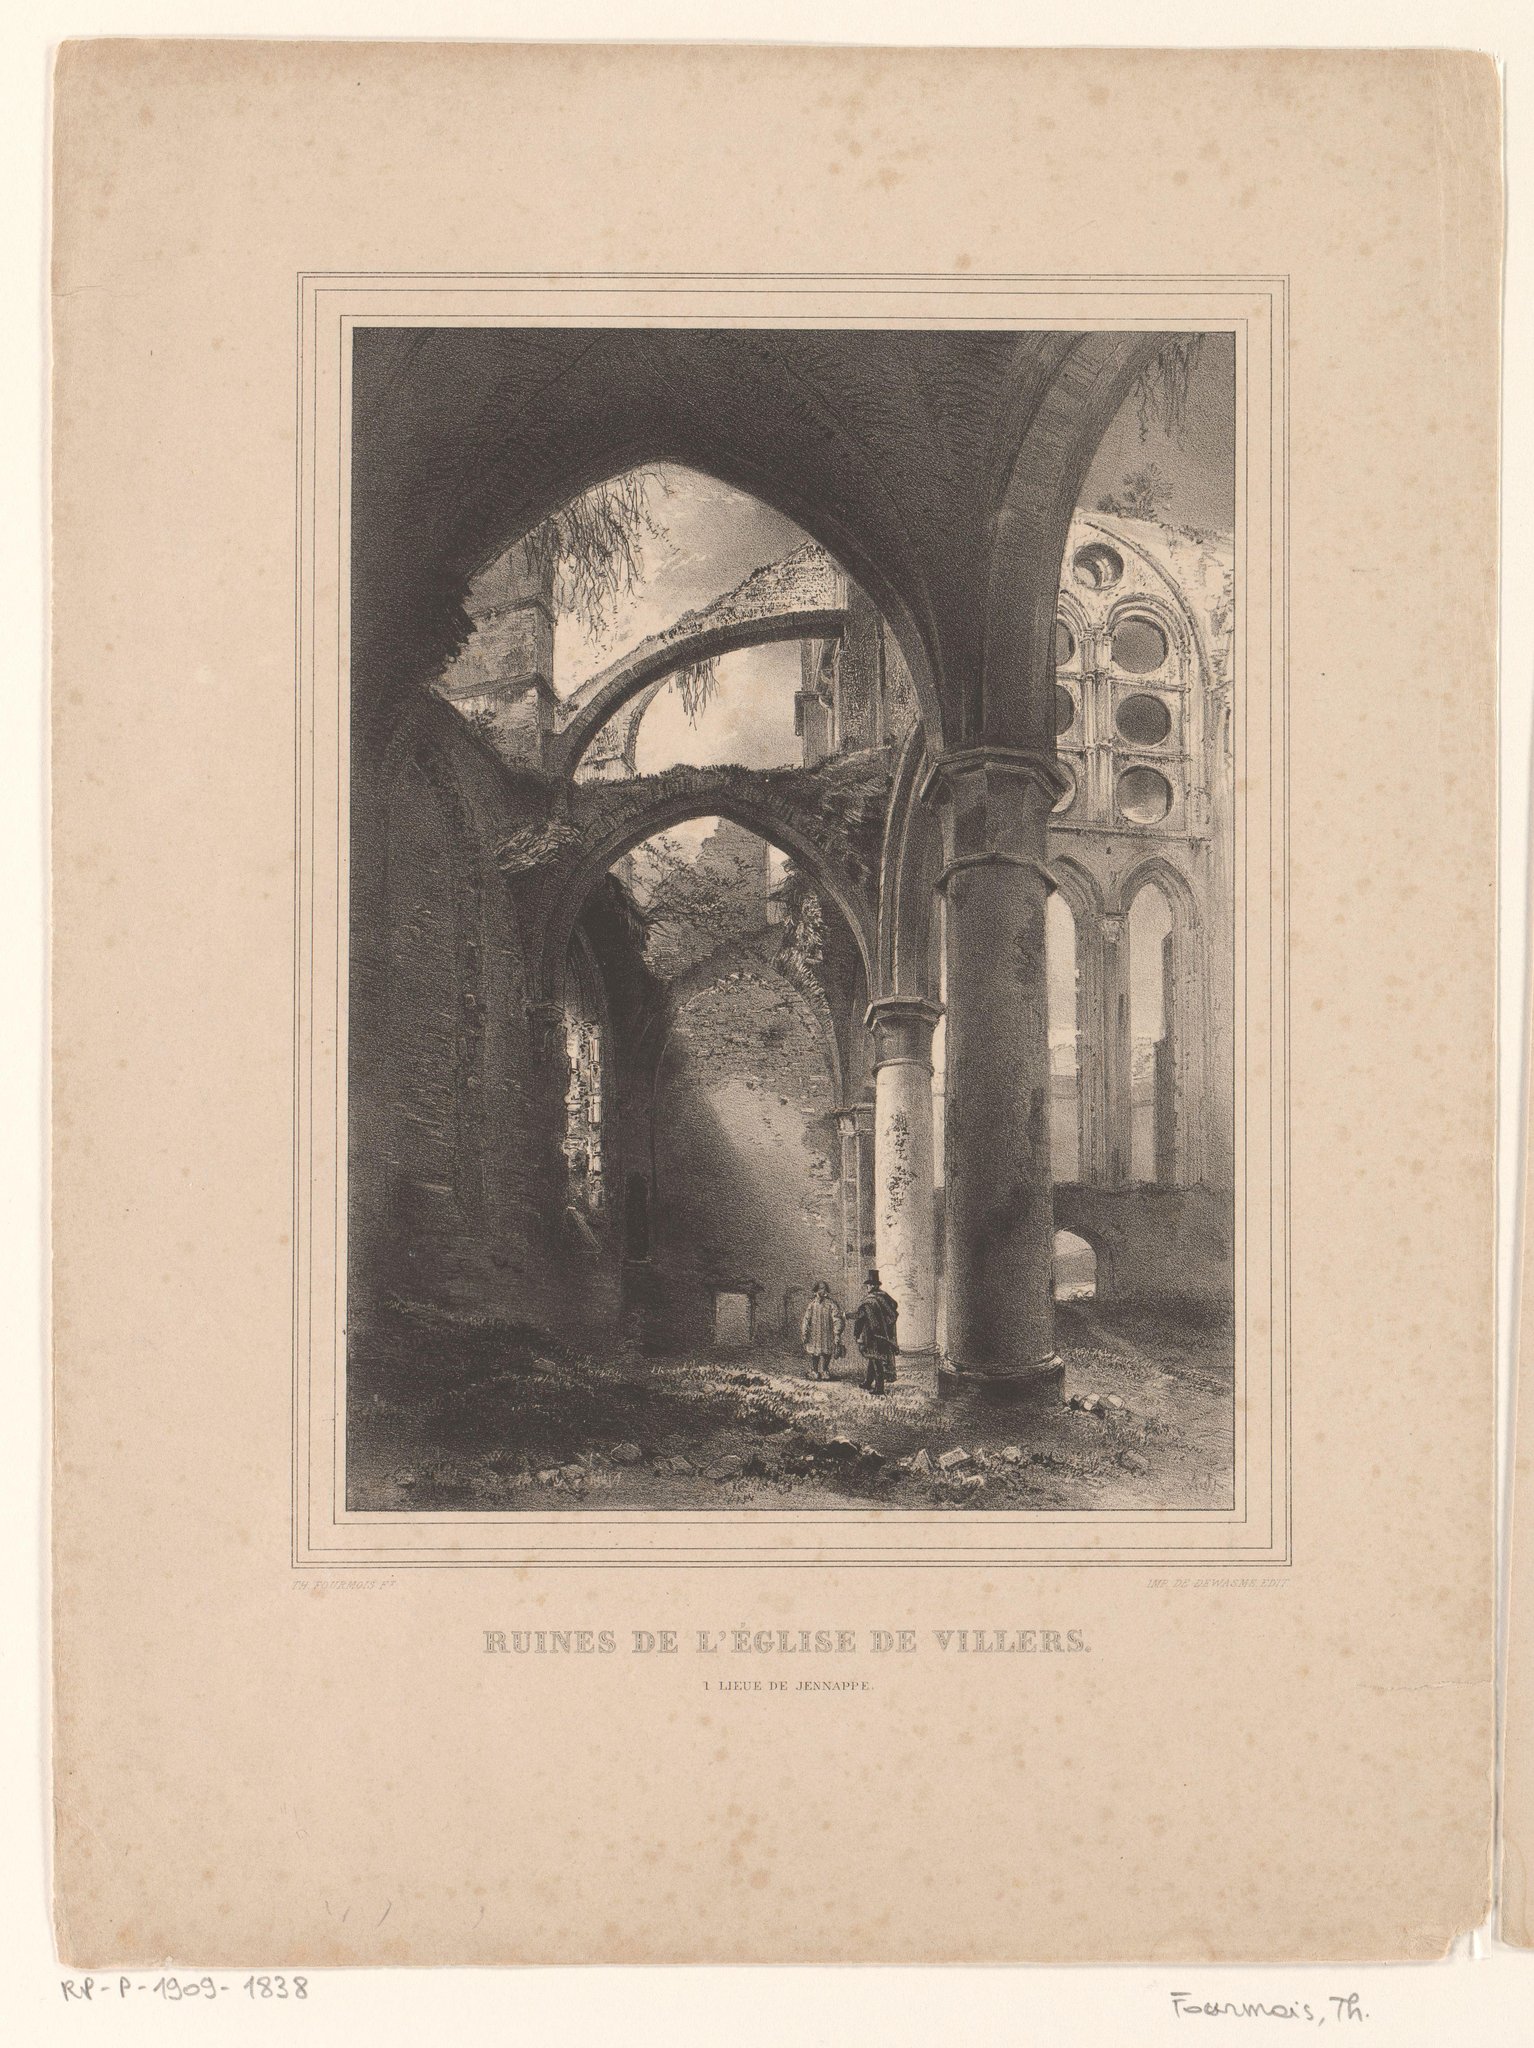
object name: print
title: Gezichten op de omgeving van Brussel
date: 1825-1827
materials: paper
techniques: lithograph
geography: brussels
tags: ruin of church, monastery, etc., landscape with ruins (+ city(-scape) with figures, staffage)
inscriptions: collector's mark: Lugt 2228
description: Prent maakt waarschijnlijk deel uit van een serie met gezichten op de omgeving van Brussel. Over deze serie is verder niets bekend. Het betreft voornamelijk landschappen en gebouwen.